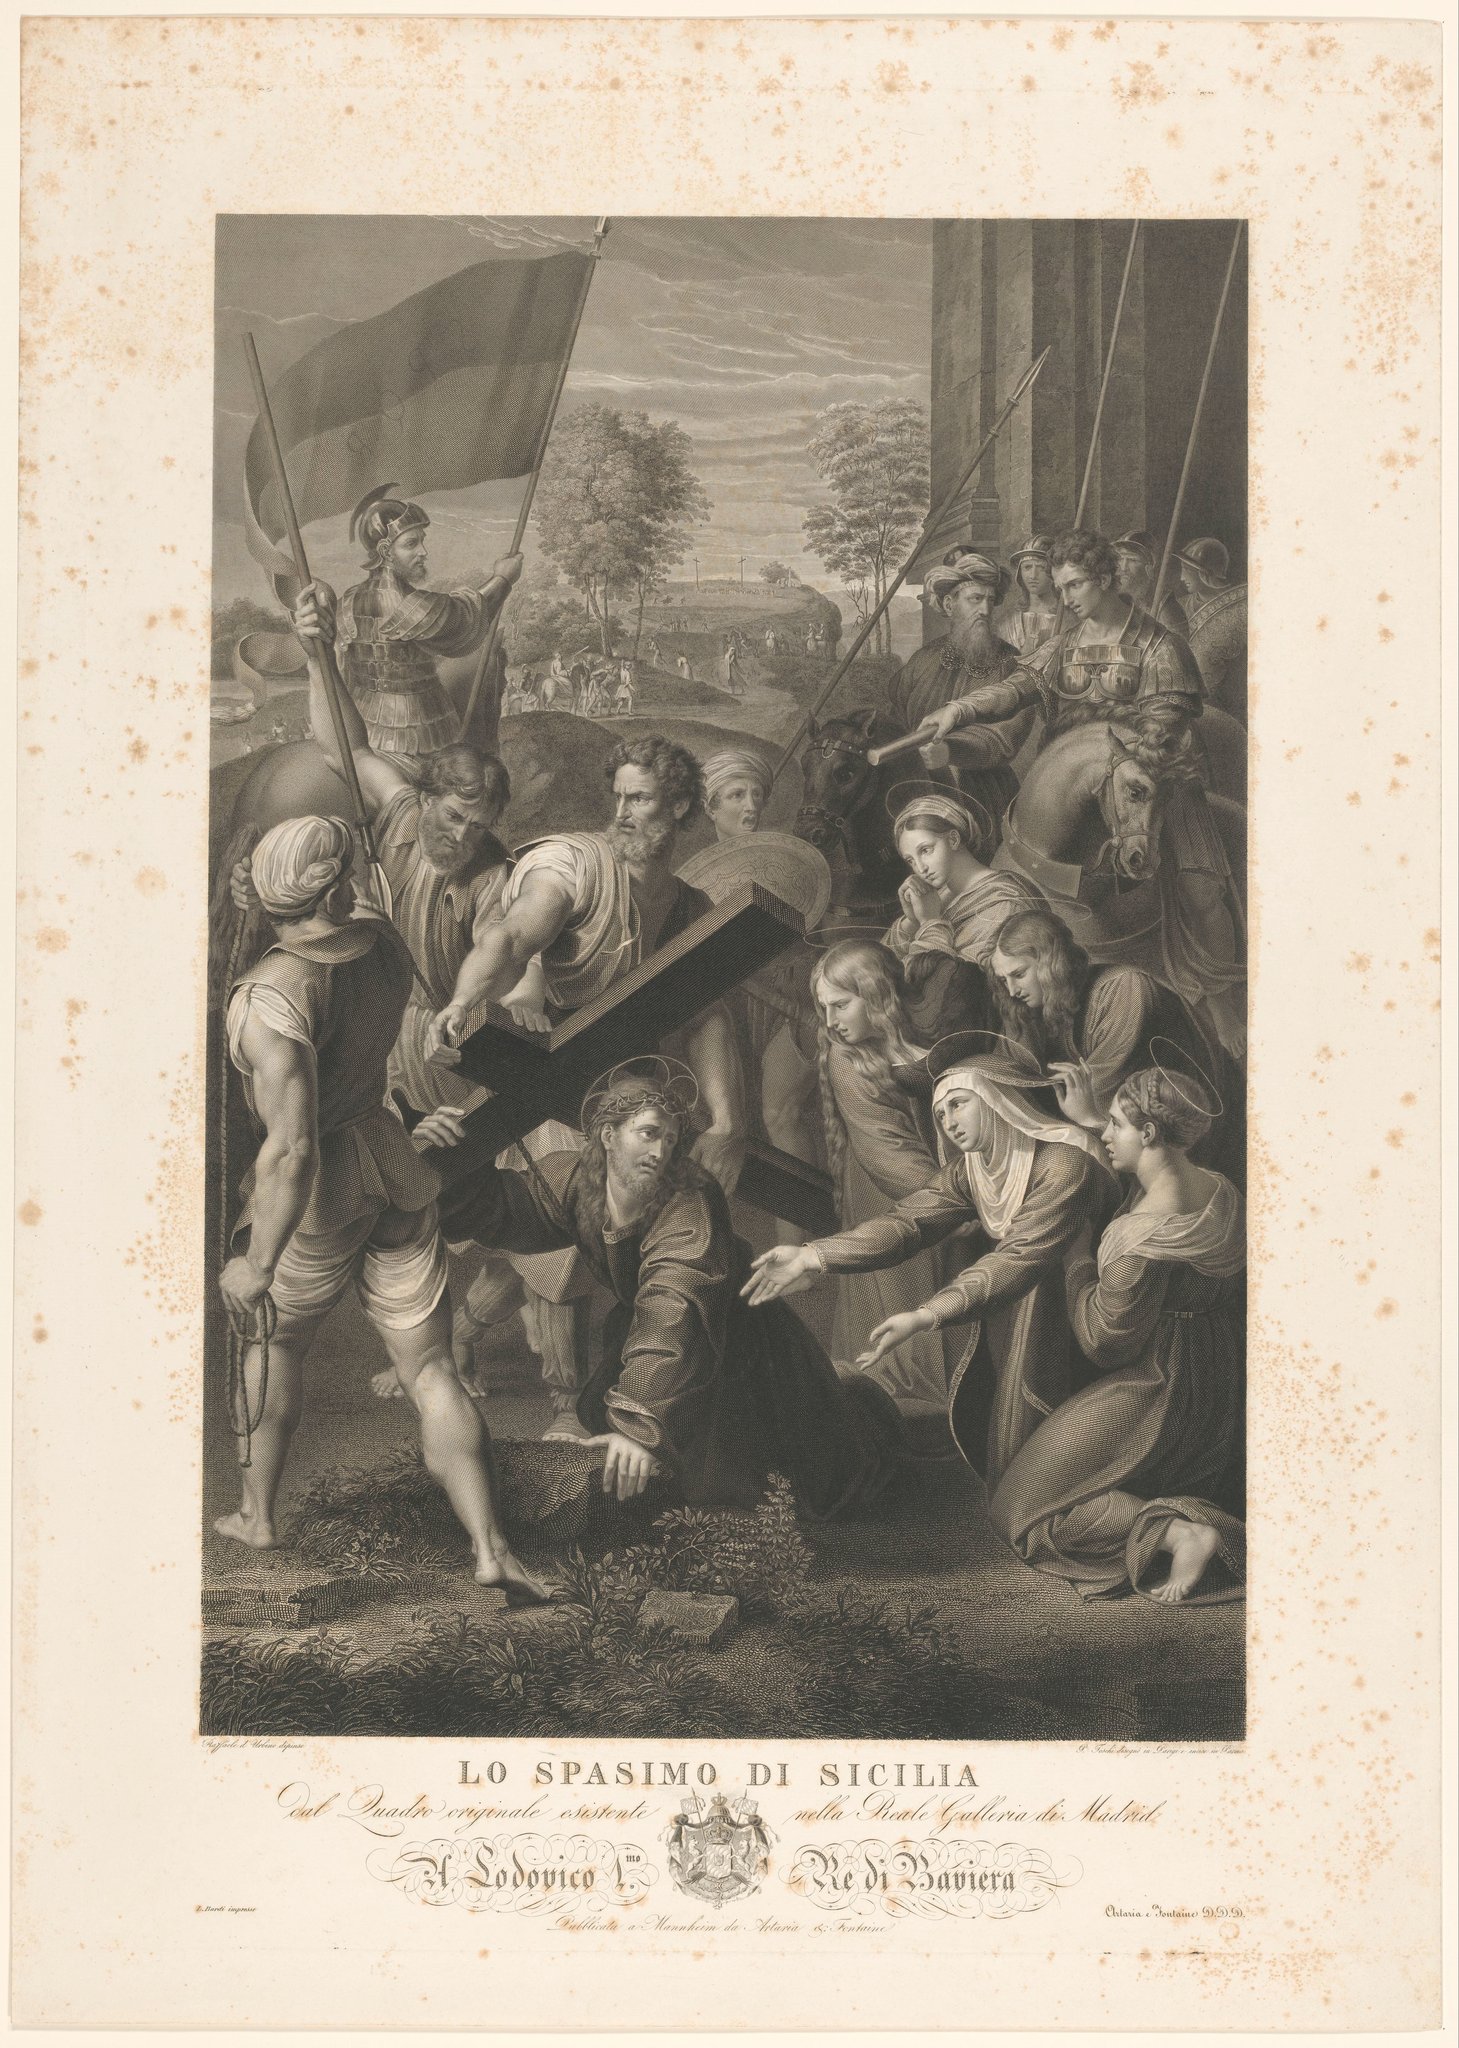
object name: print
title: Lo spasimo di Sicilia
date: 1798-1854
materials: paper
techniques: engraving, etching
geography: italy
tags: carrying of the cross: christ bearing the cross, alone or with the help of others (e.g. simon the cyrenian)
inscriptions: collector's mark: Lugt 12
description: Christus bezwijkt onder het gewicht van het kruis dat hij op zijn schouders draagt op de weg naar Golgota. Soldaten trekken aan Christus met touwen en richten hun speren op hem. Christus kijkt om naar de Maria's en Johannes de Evangelist. Titel, opdracht en wapen in ondermarge.